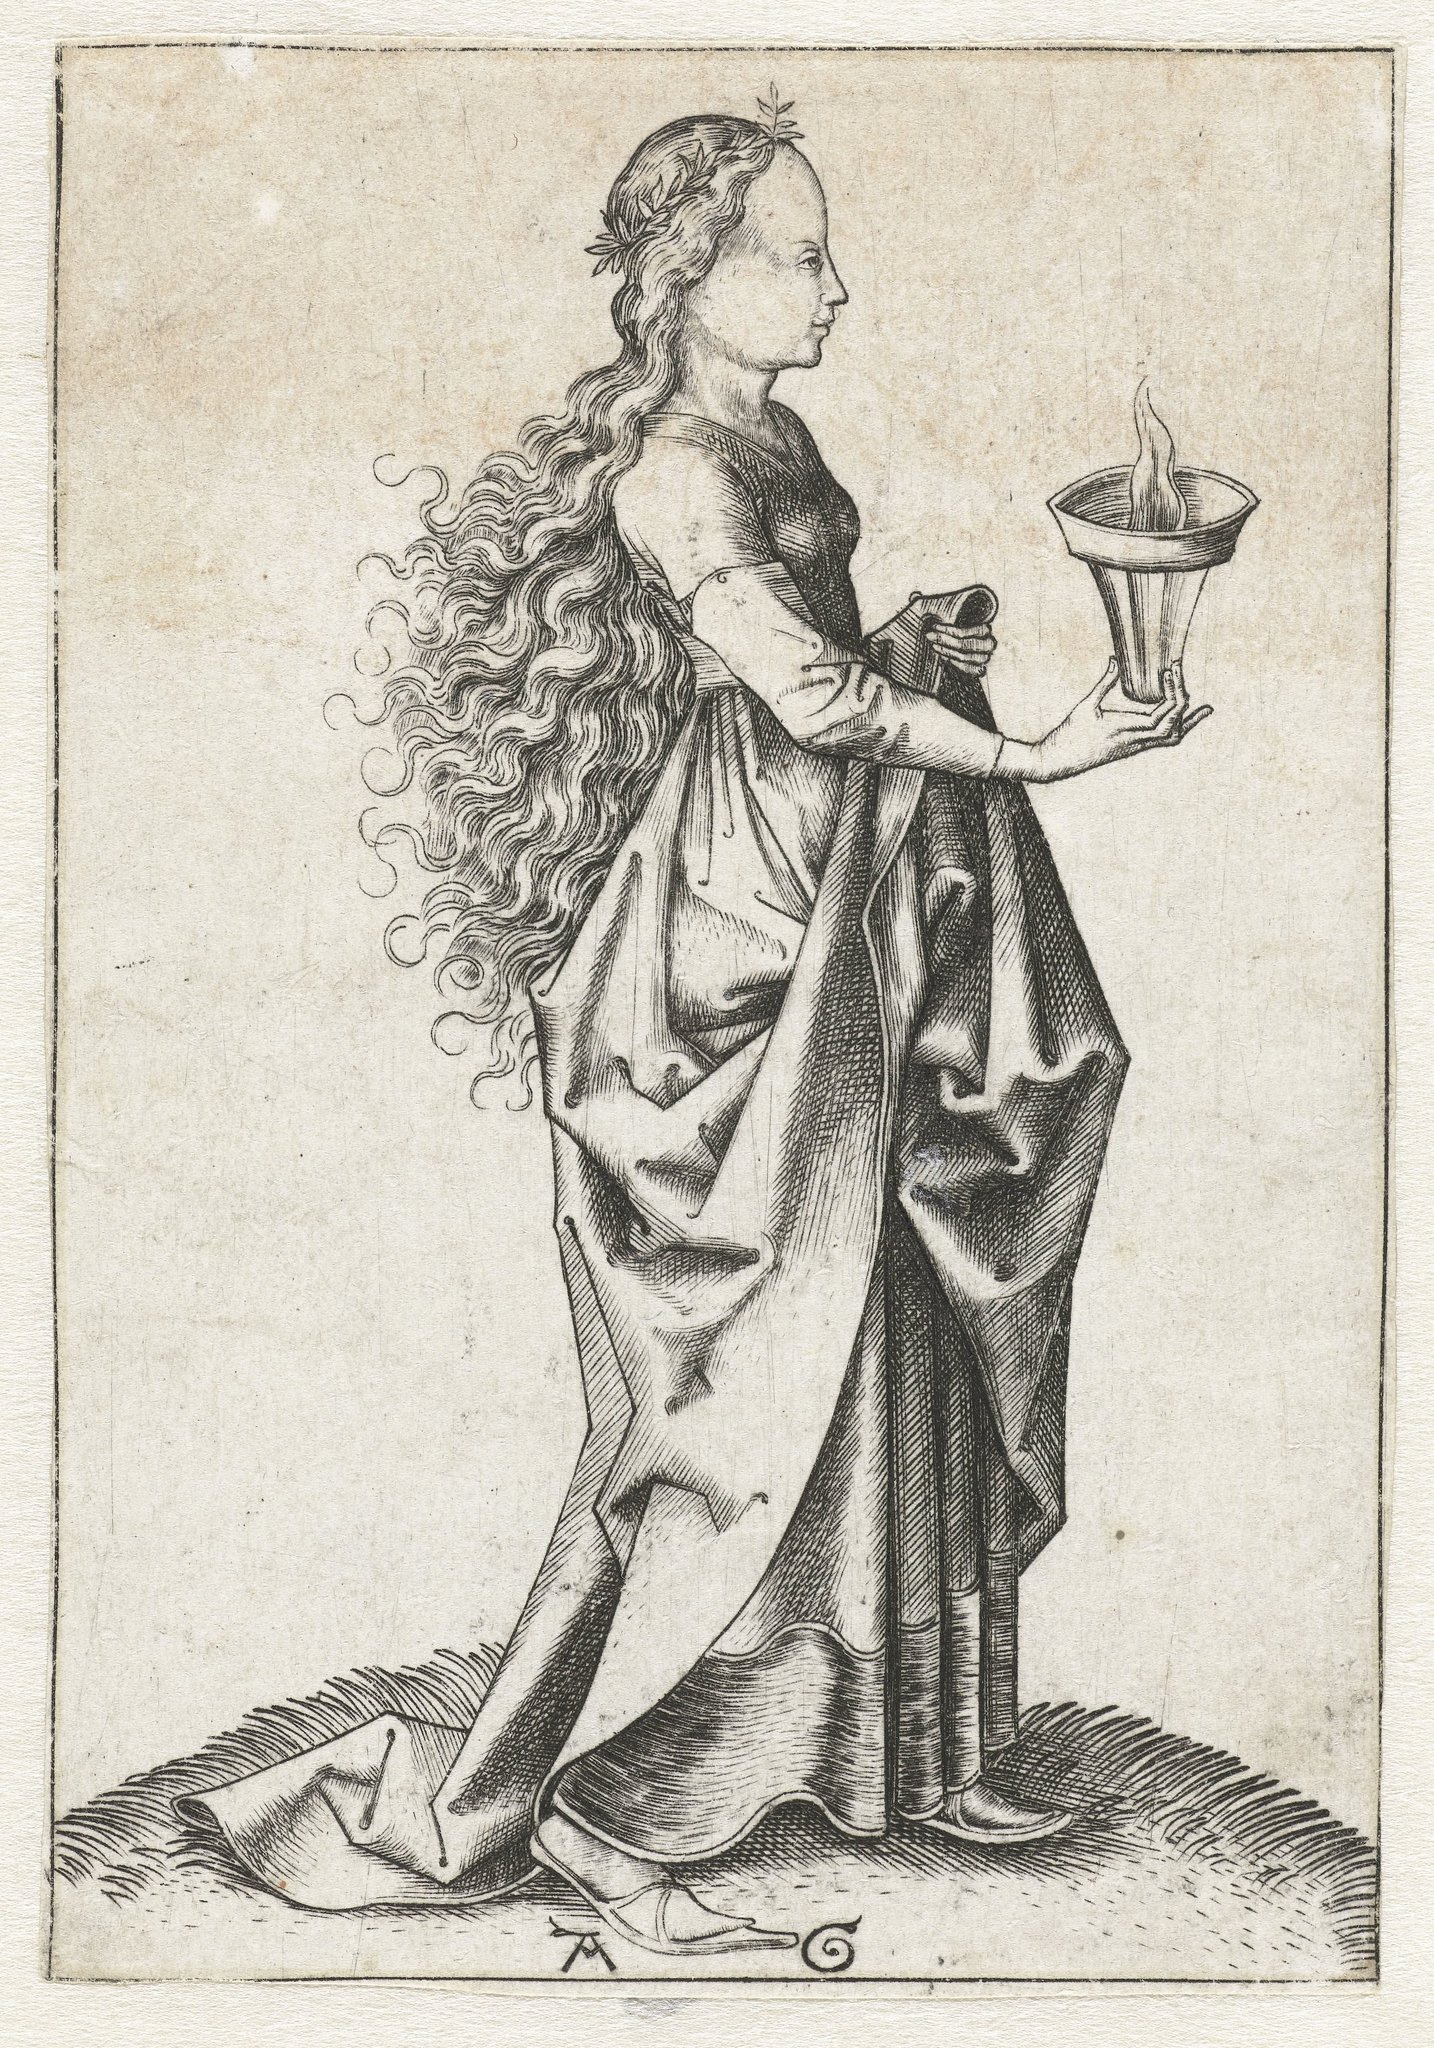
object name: print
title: Vijf wijze en vijf dwaze maagden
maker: monogrammist ag (15e eeuw)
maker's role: print maker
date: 1475-1500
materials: paper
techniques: engraving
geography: germany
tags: representation of wise virgin(s)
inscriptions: collector's mark: Lugt 240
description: Een van de vijf wijze maagden uit de bijbelse parabel over de vijf wijze en vijf dwaze maagden. Een lauwerkrans op haar hoofd en de brandende olielamp in de rechterhand.